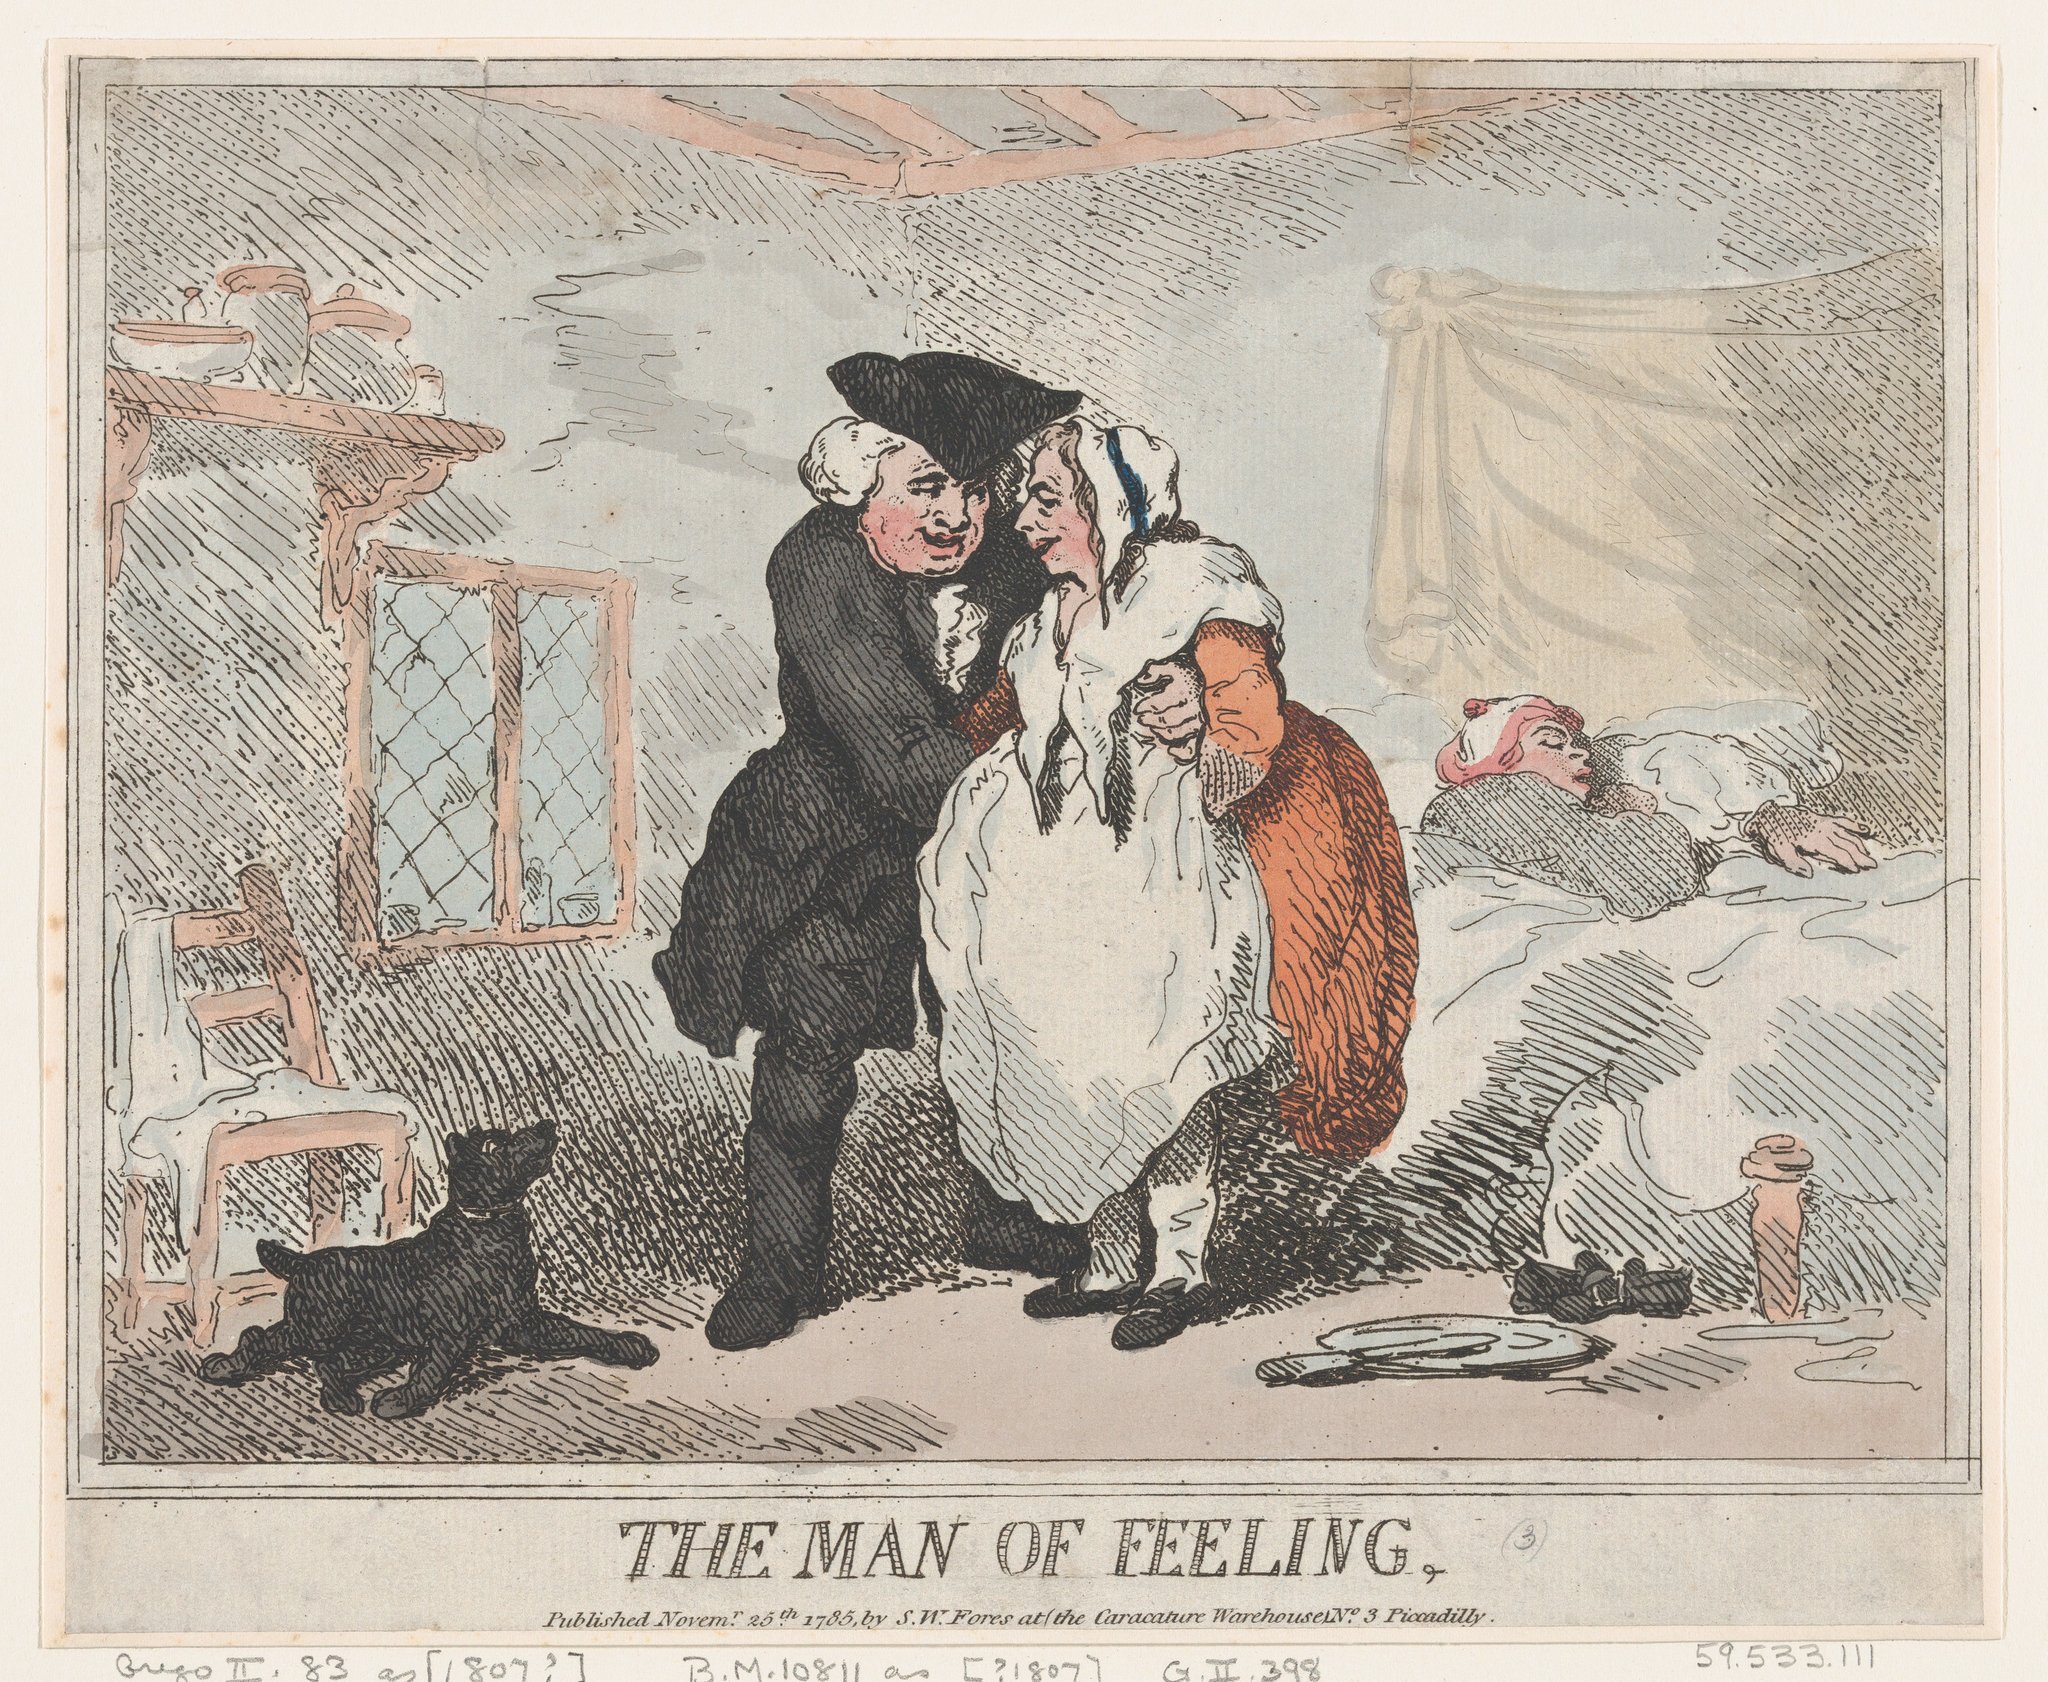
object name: print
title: The Man of Feeling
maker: thomas rowlandson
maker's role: artist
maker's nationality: british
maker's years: 1757-1827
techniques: etching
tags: sleeping,men,women,dogs